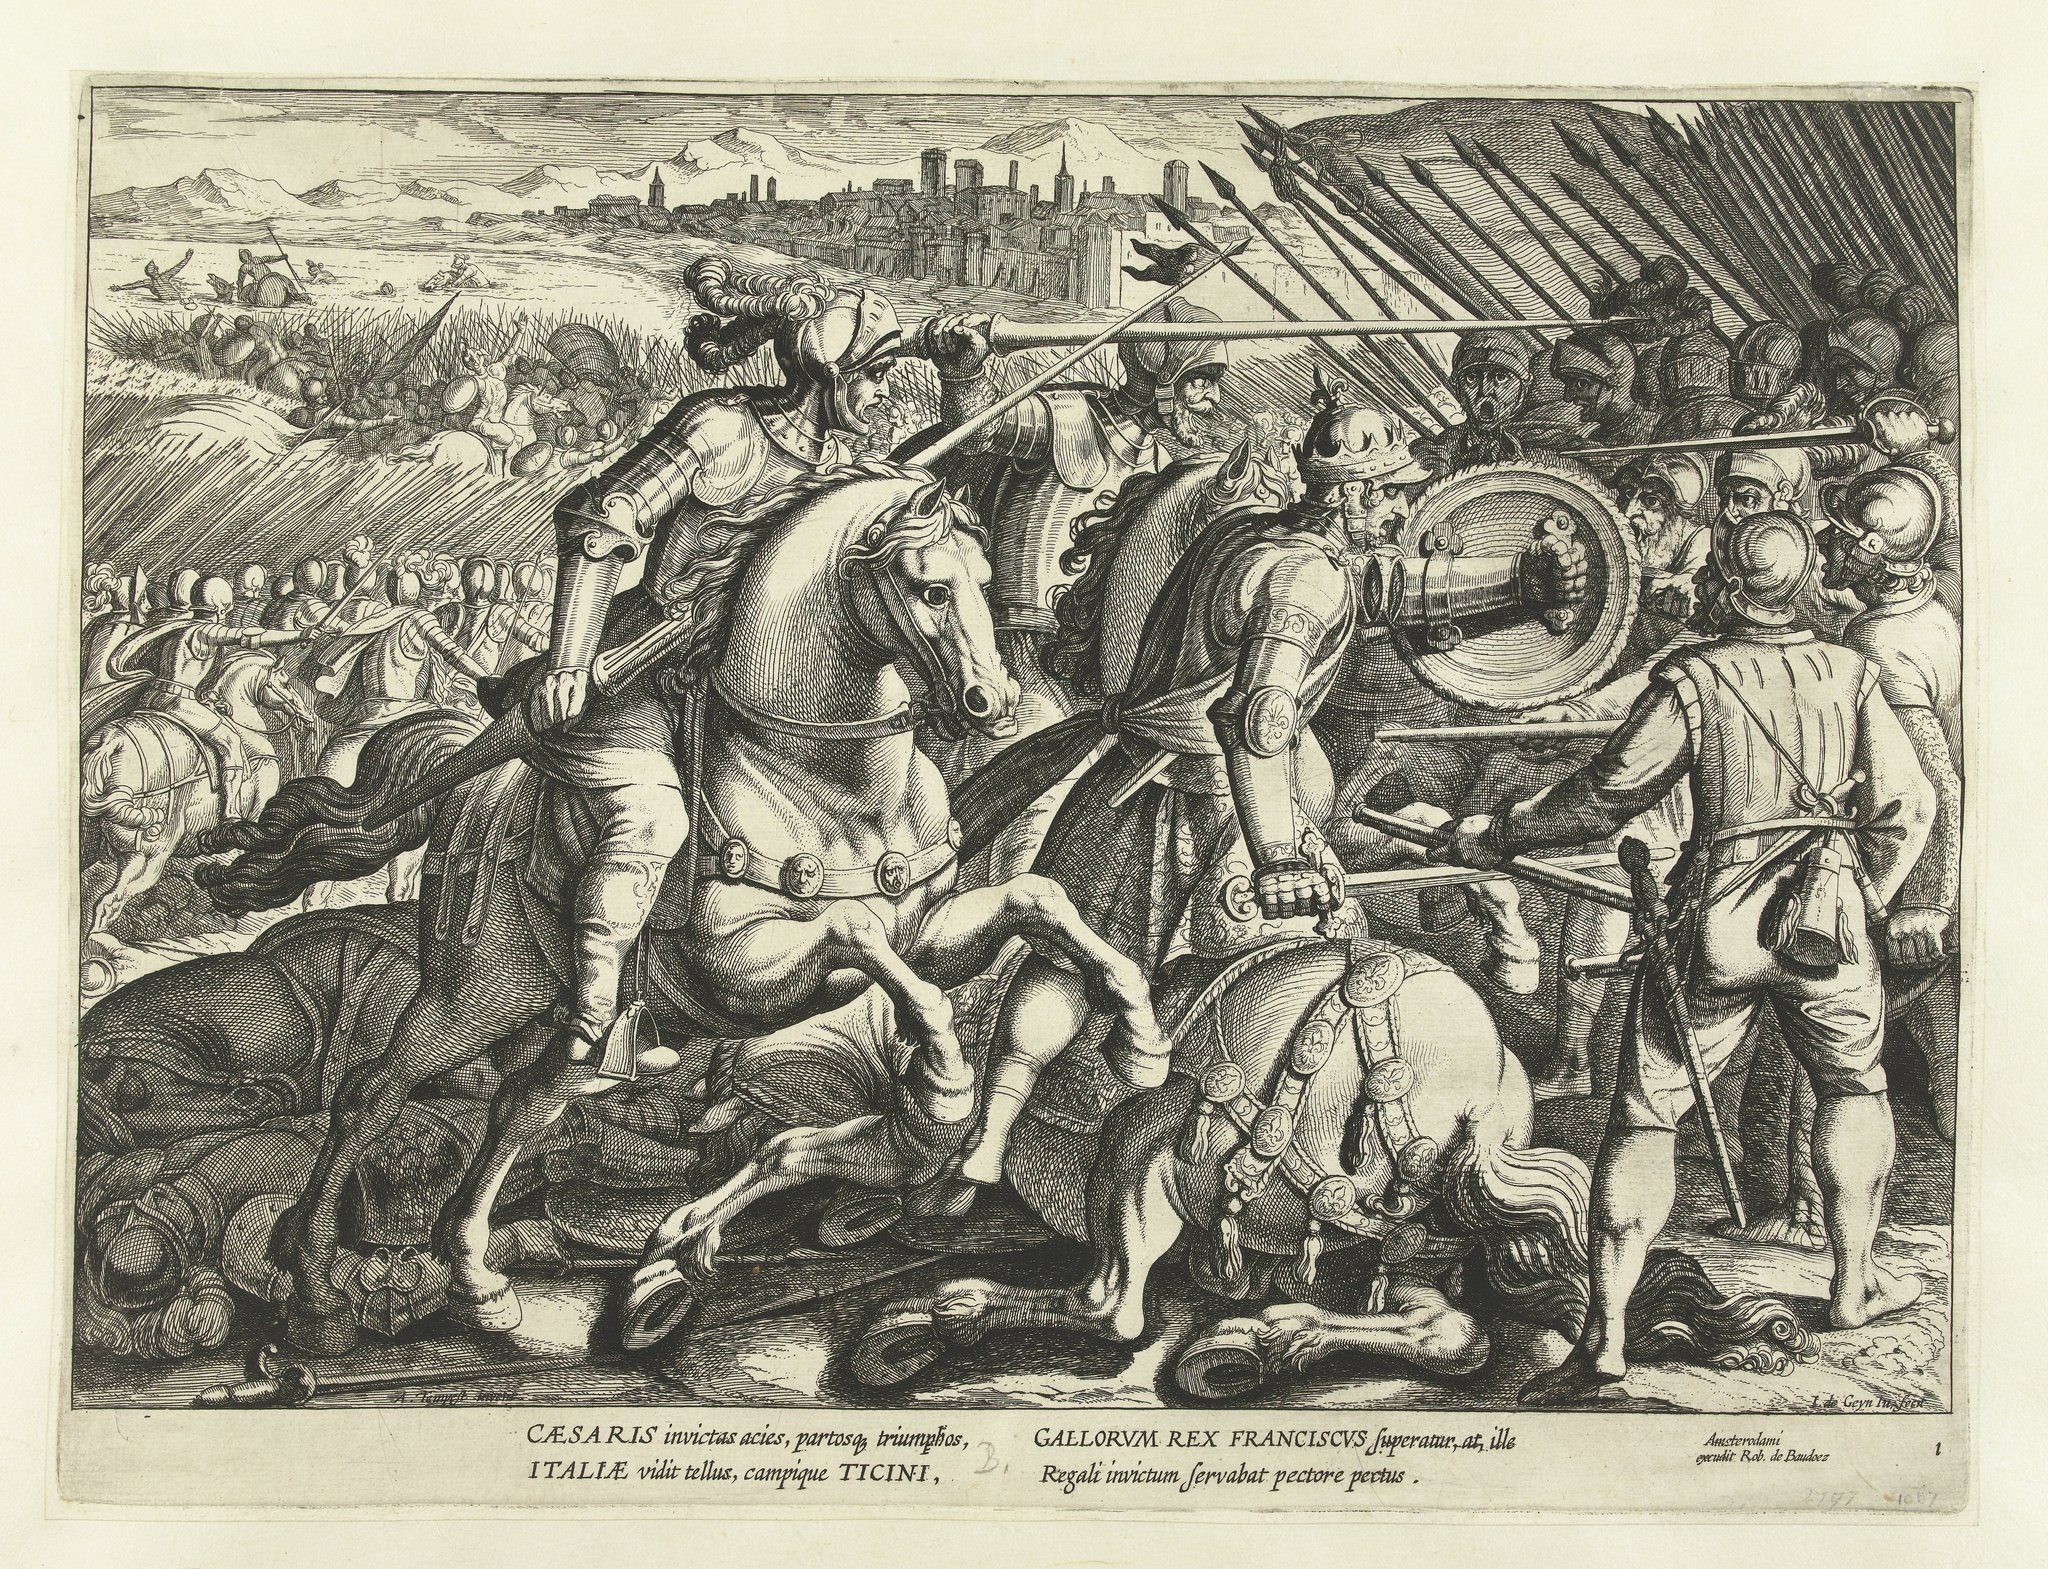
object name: print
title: Overwinning van keizer Karel V op Frans I van Frankrijk bij Pavia, 1525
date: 1614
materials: paper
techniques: engraving, etching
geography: netherlands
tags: frans i van valois-angoulême (koning van frankrijk), ghent, charles v (holy roman emperor and king of spain), battle, fighting in general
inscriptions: collector's mark: Lugt 240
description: Overwinning van Karel V op Frans I, koning van Frankrijk in de slag bij Pavia in 1525. De soldaten van Karel V verslaan in gevecht de Franse soldaten. Rechts op de achtergrond een stad aan een kust. Met onderschrift van vier regels in het Latijn. Deze prent is onderdeel van een reeks van acht prenten, elk een triomf van Karel V voorstellende.